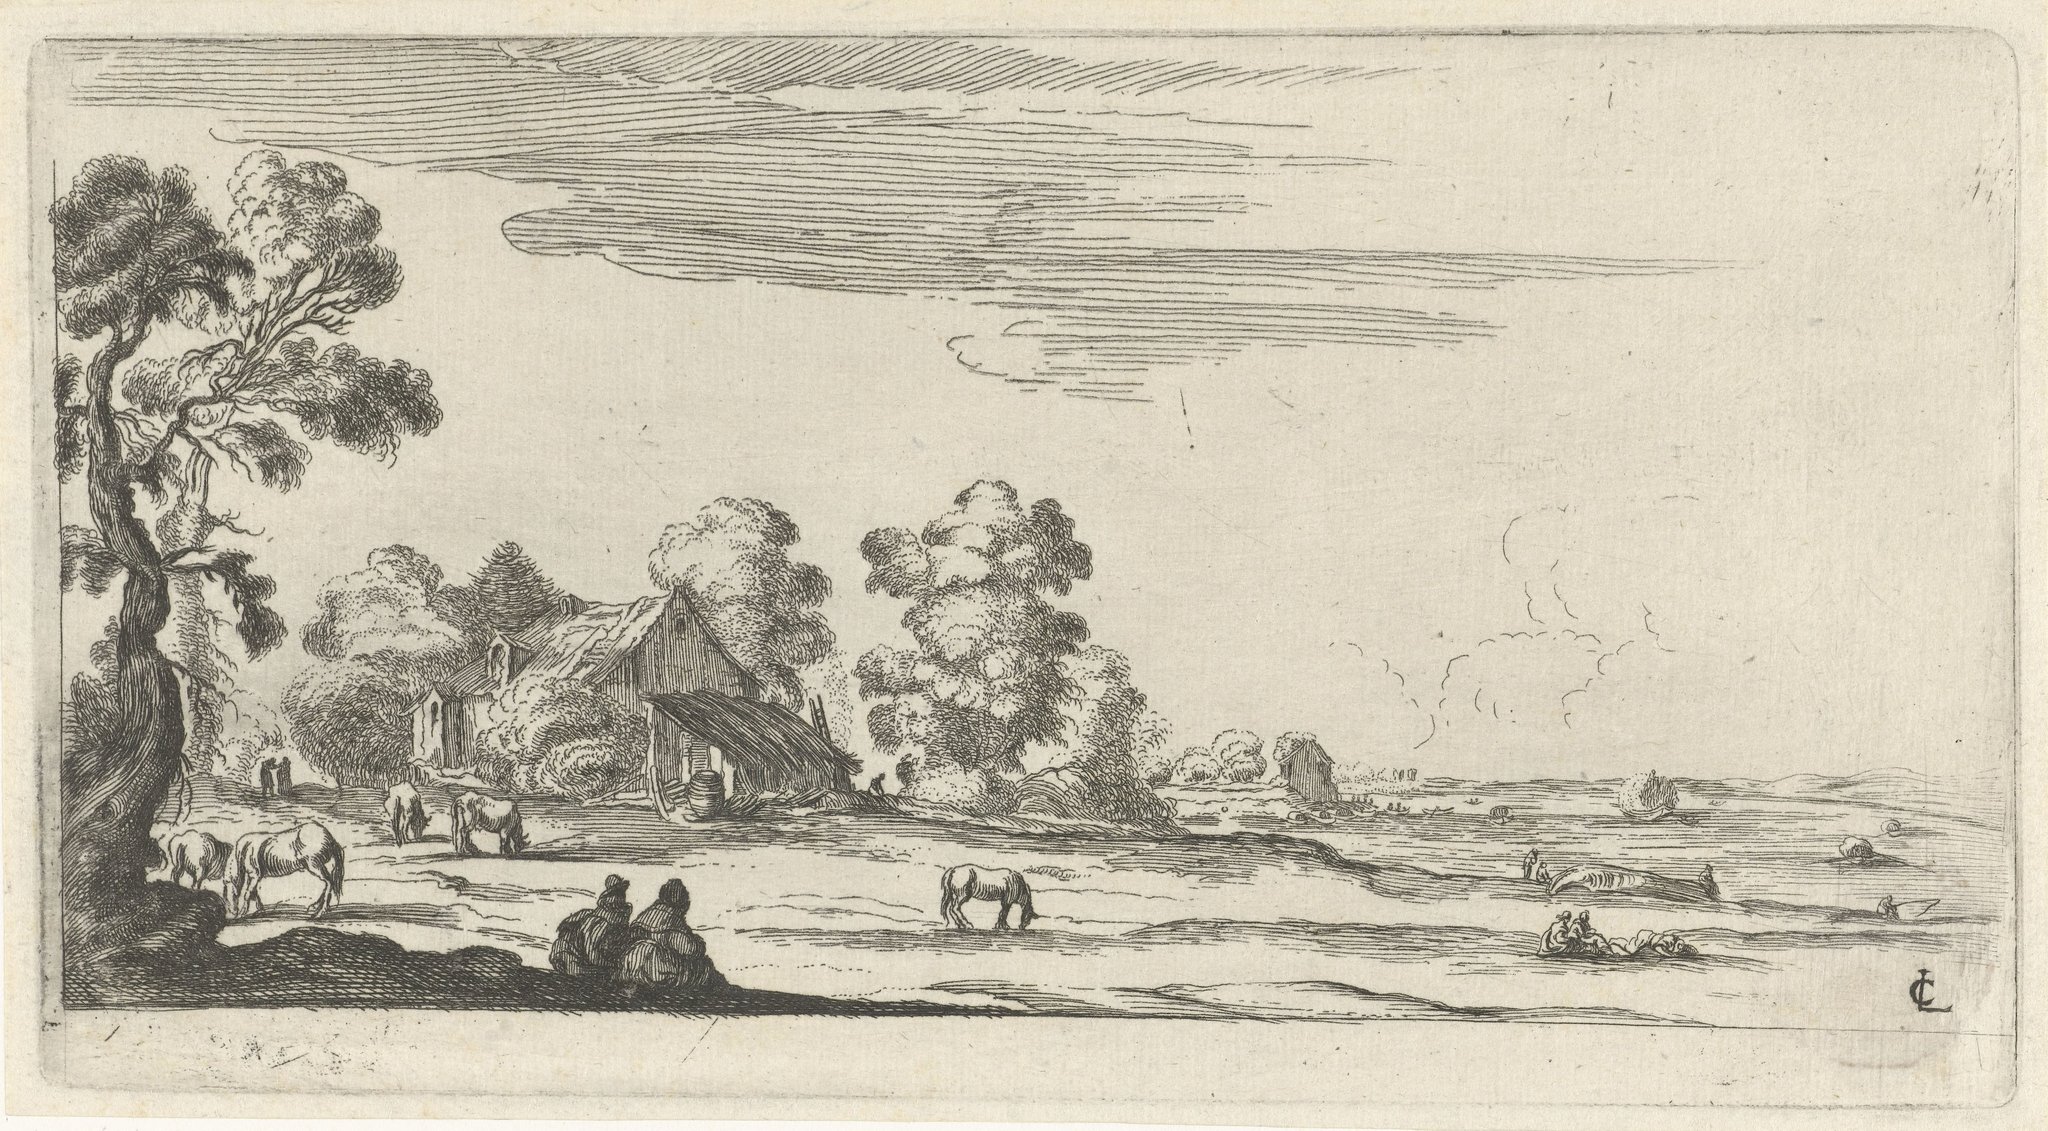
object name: print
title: Landschap met hoeve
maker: lievin cruyl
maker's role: draughtsman, print maker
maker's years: 1634-1720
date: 1650-1720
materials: paper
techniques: etching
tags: farm or solitary house in landscape (+ city(-scape) with figures, staffage)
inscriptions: collector's mark: Lugt 240